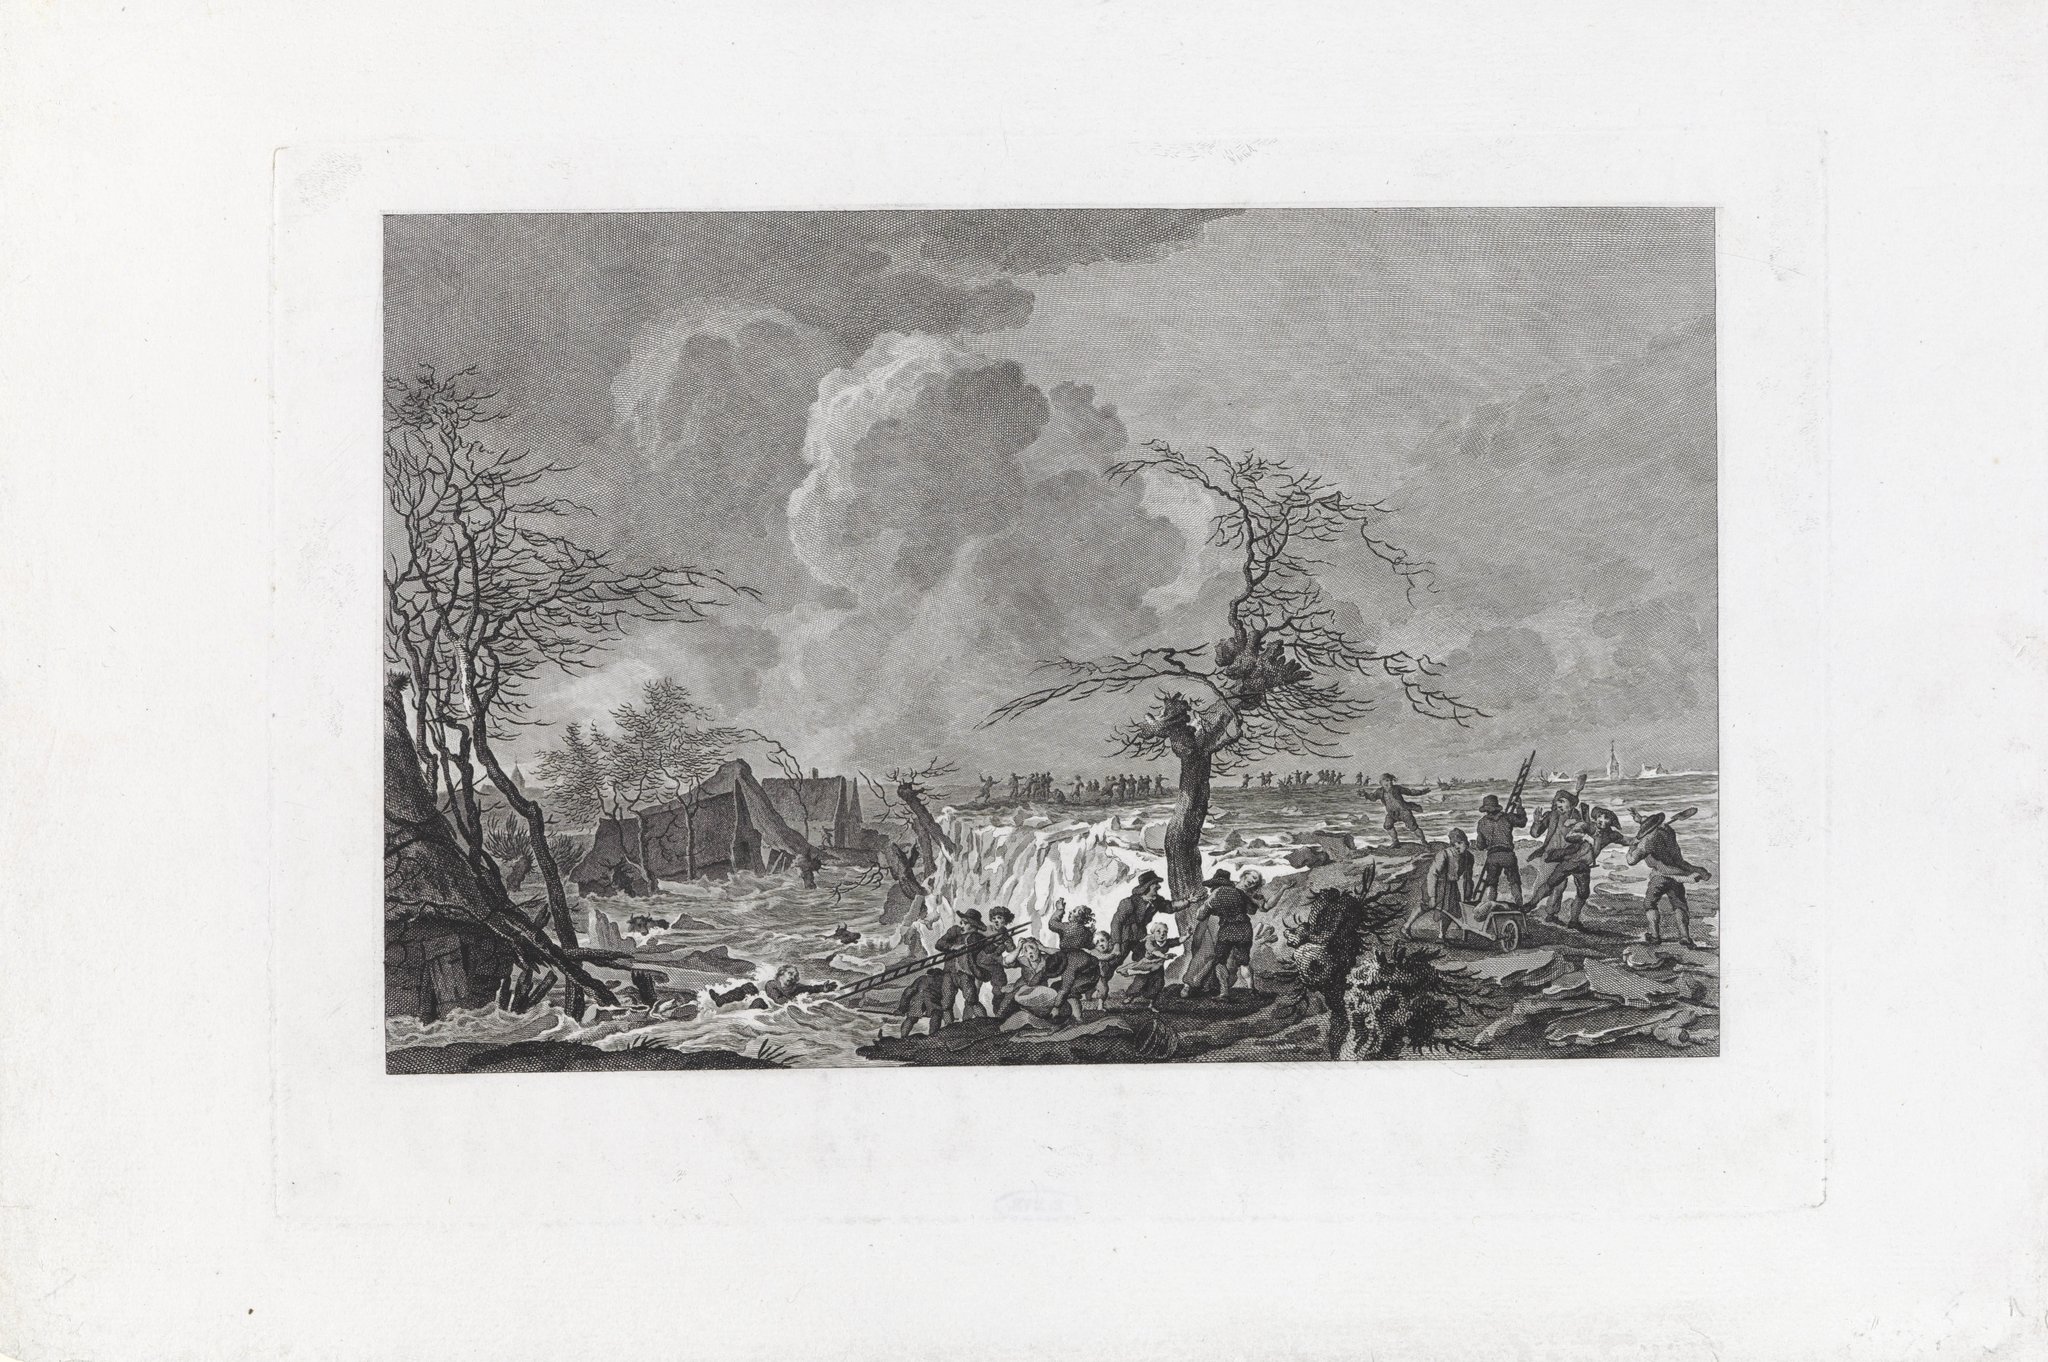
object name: print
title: Dijkdoorbraak bij Doornik, 1799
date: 1799-1800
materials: paper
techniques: engraving, etching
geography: netherlands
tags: dike-break, storm on land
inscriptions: collector's mark: Lugt 2228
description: Doorbraak van Waaldijk bij Doornik, tussen Bemmel en Lent, 21 februari 1799. Onderdeel van een groep van zes platen van dijkdoorbraken en watersnood in het zuidelijk deel van Gelderland in februari 1799.